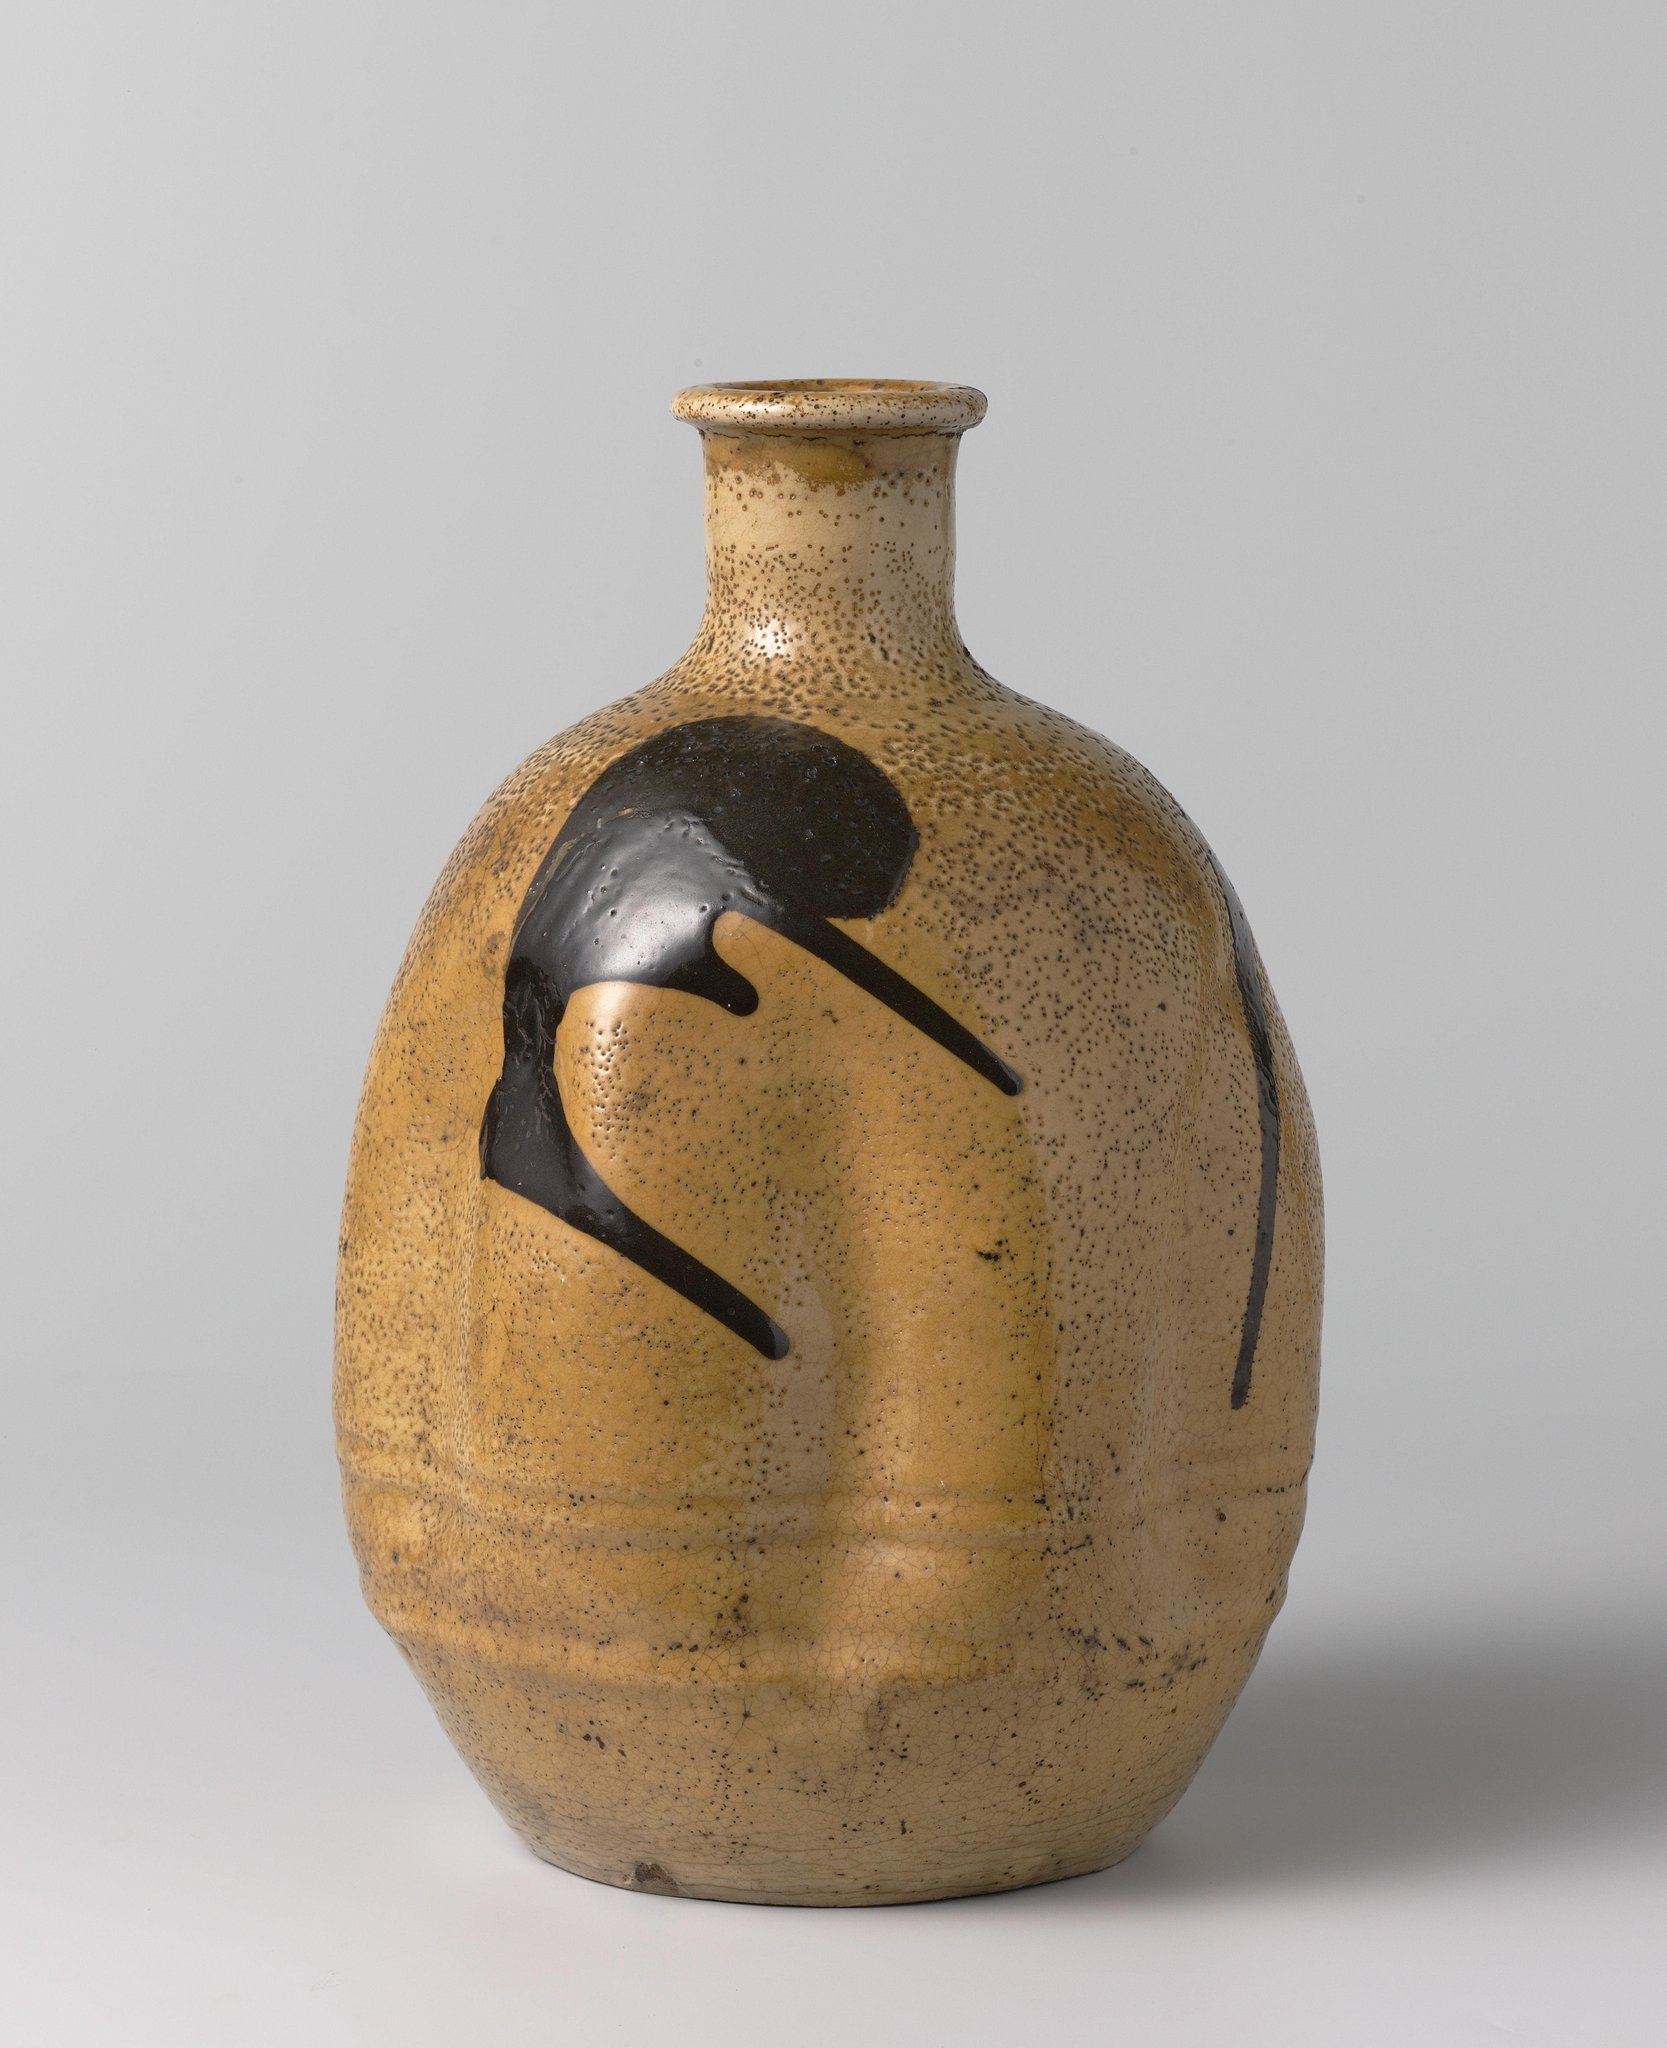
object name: sakefles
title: Ovoid sake bottle with a yellow glaze and brown marks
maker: Anonymous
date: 1750-1850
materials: wood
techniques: firing, forming, turning, vitrification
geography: japan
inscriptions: label: ‘W504’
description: Geelbruine scherf. Gelige glazuur met vier donkerbruine vlekken.